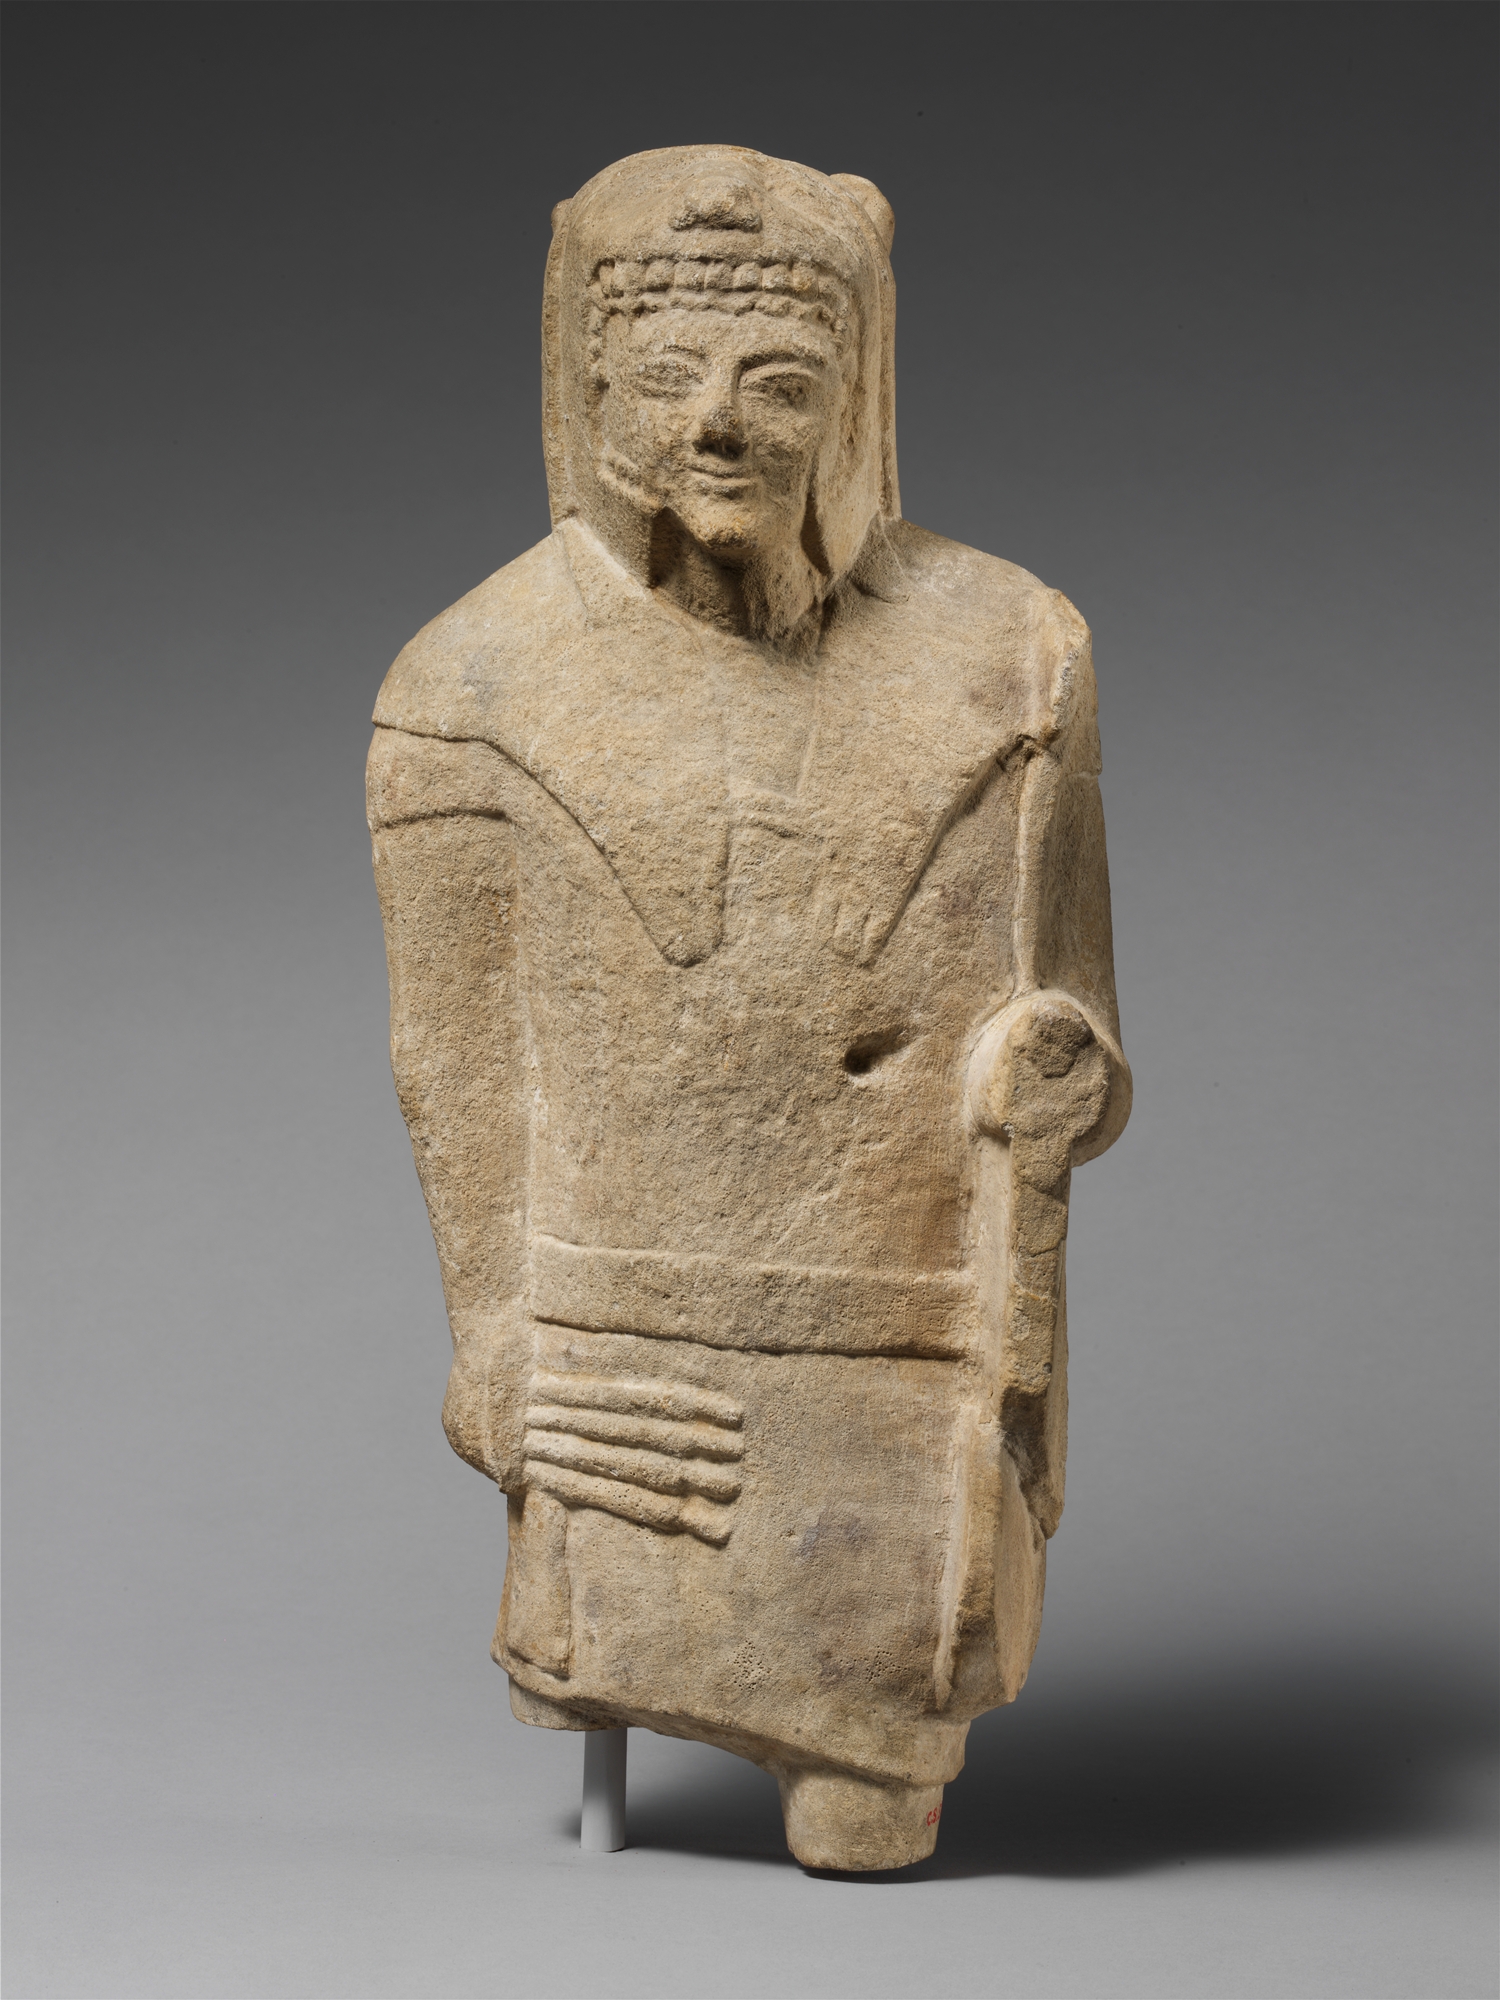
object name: statuette of herakles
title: Limestone statuette of Herakles as an archer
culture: cypriot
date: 550-501 BCE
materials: limestone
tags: herakles